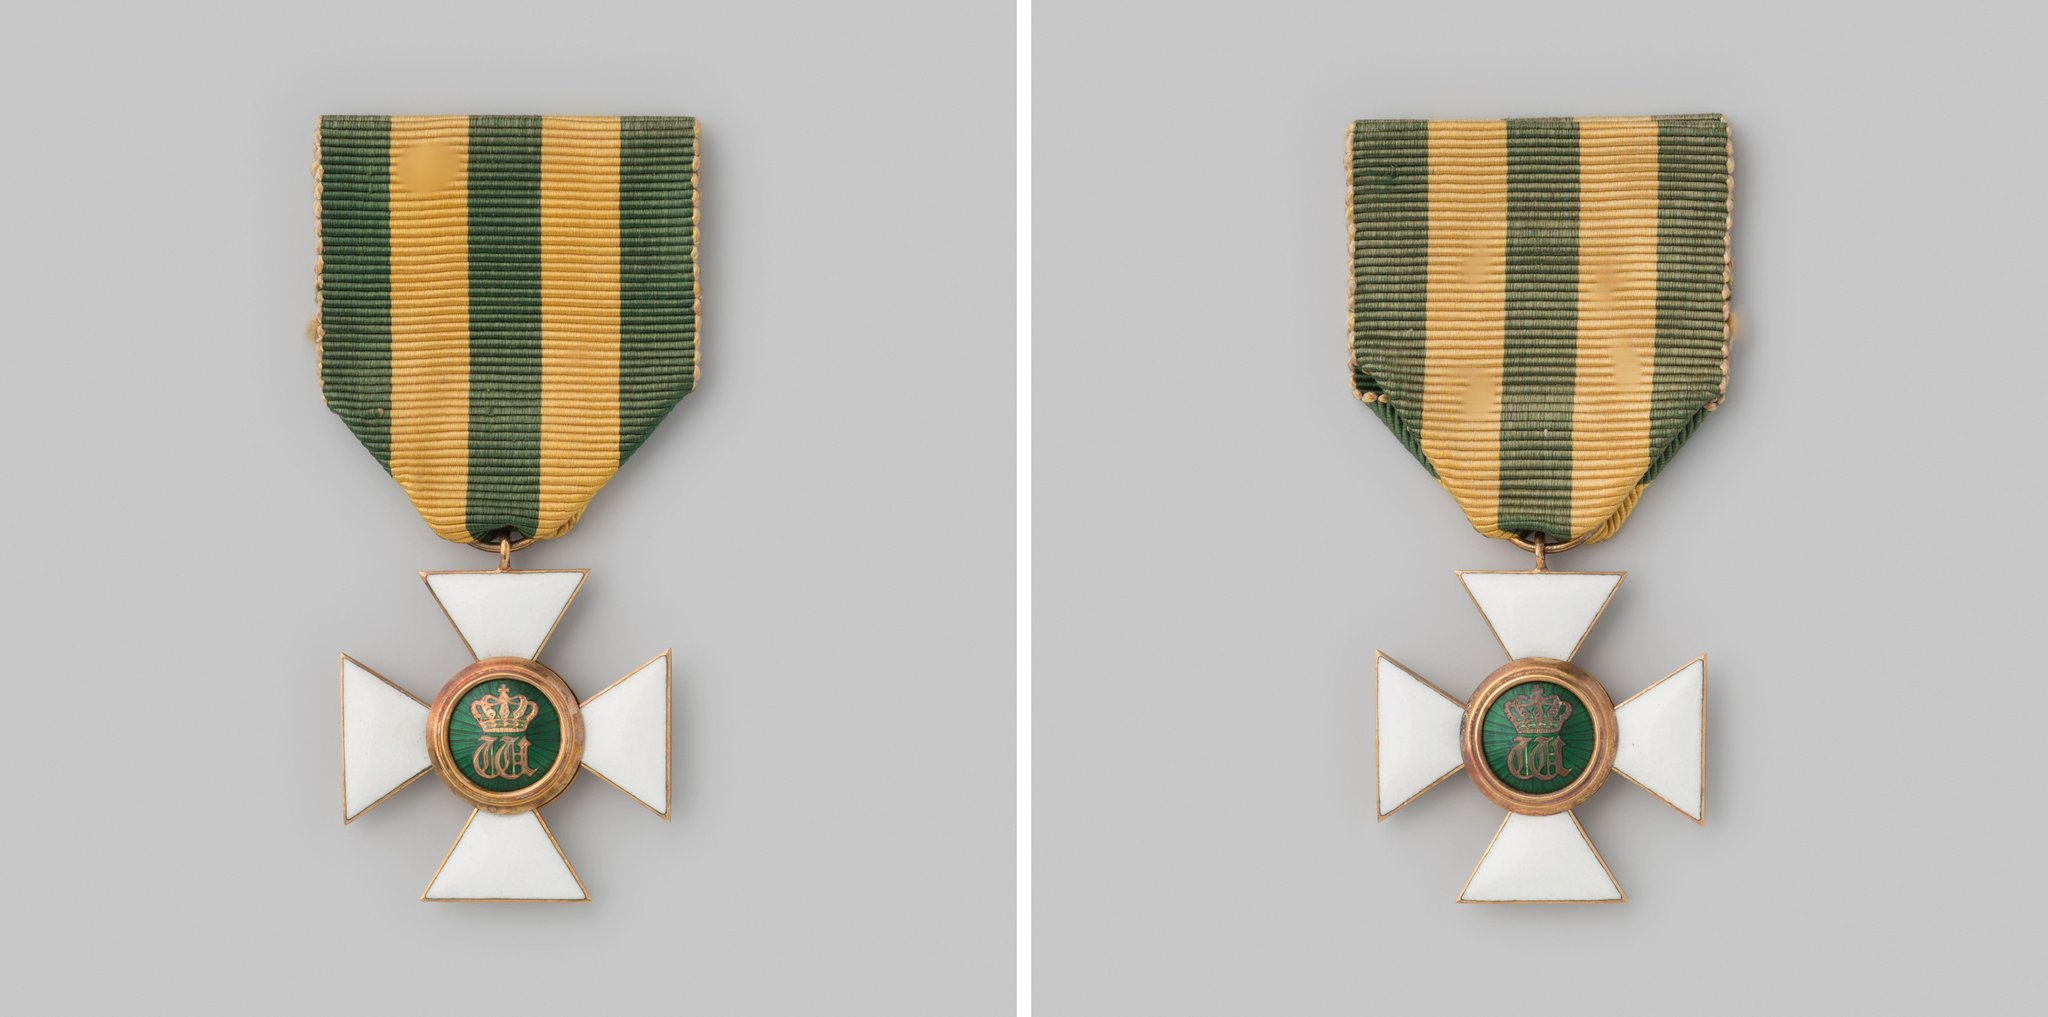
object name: insignia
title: Ridderkruis van de orde van de Eikenkroon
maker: Anonymous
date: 1841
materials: gold, silver, textile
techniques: gilding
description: Zilveren draagpenning, email met goud, oog, ring en lint.